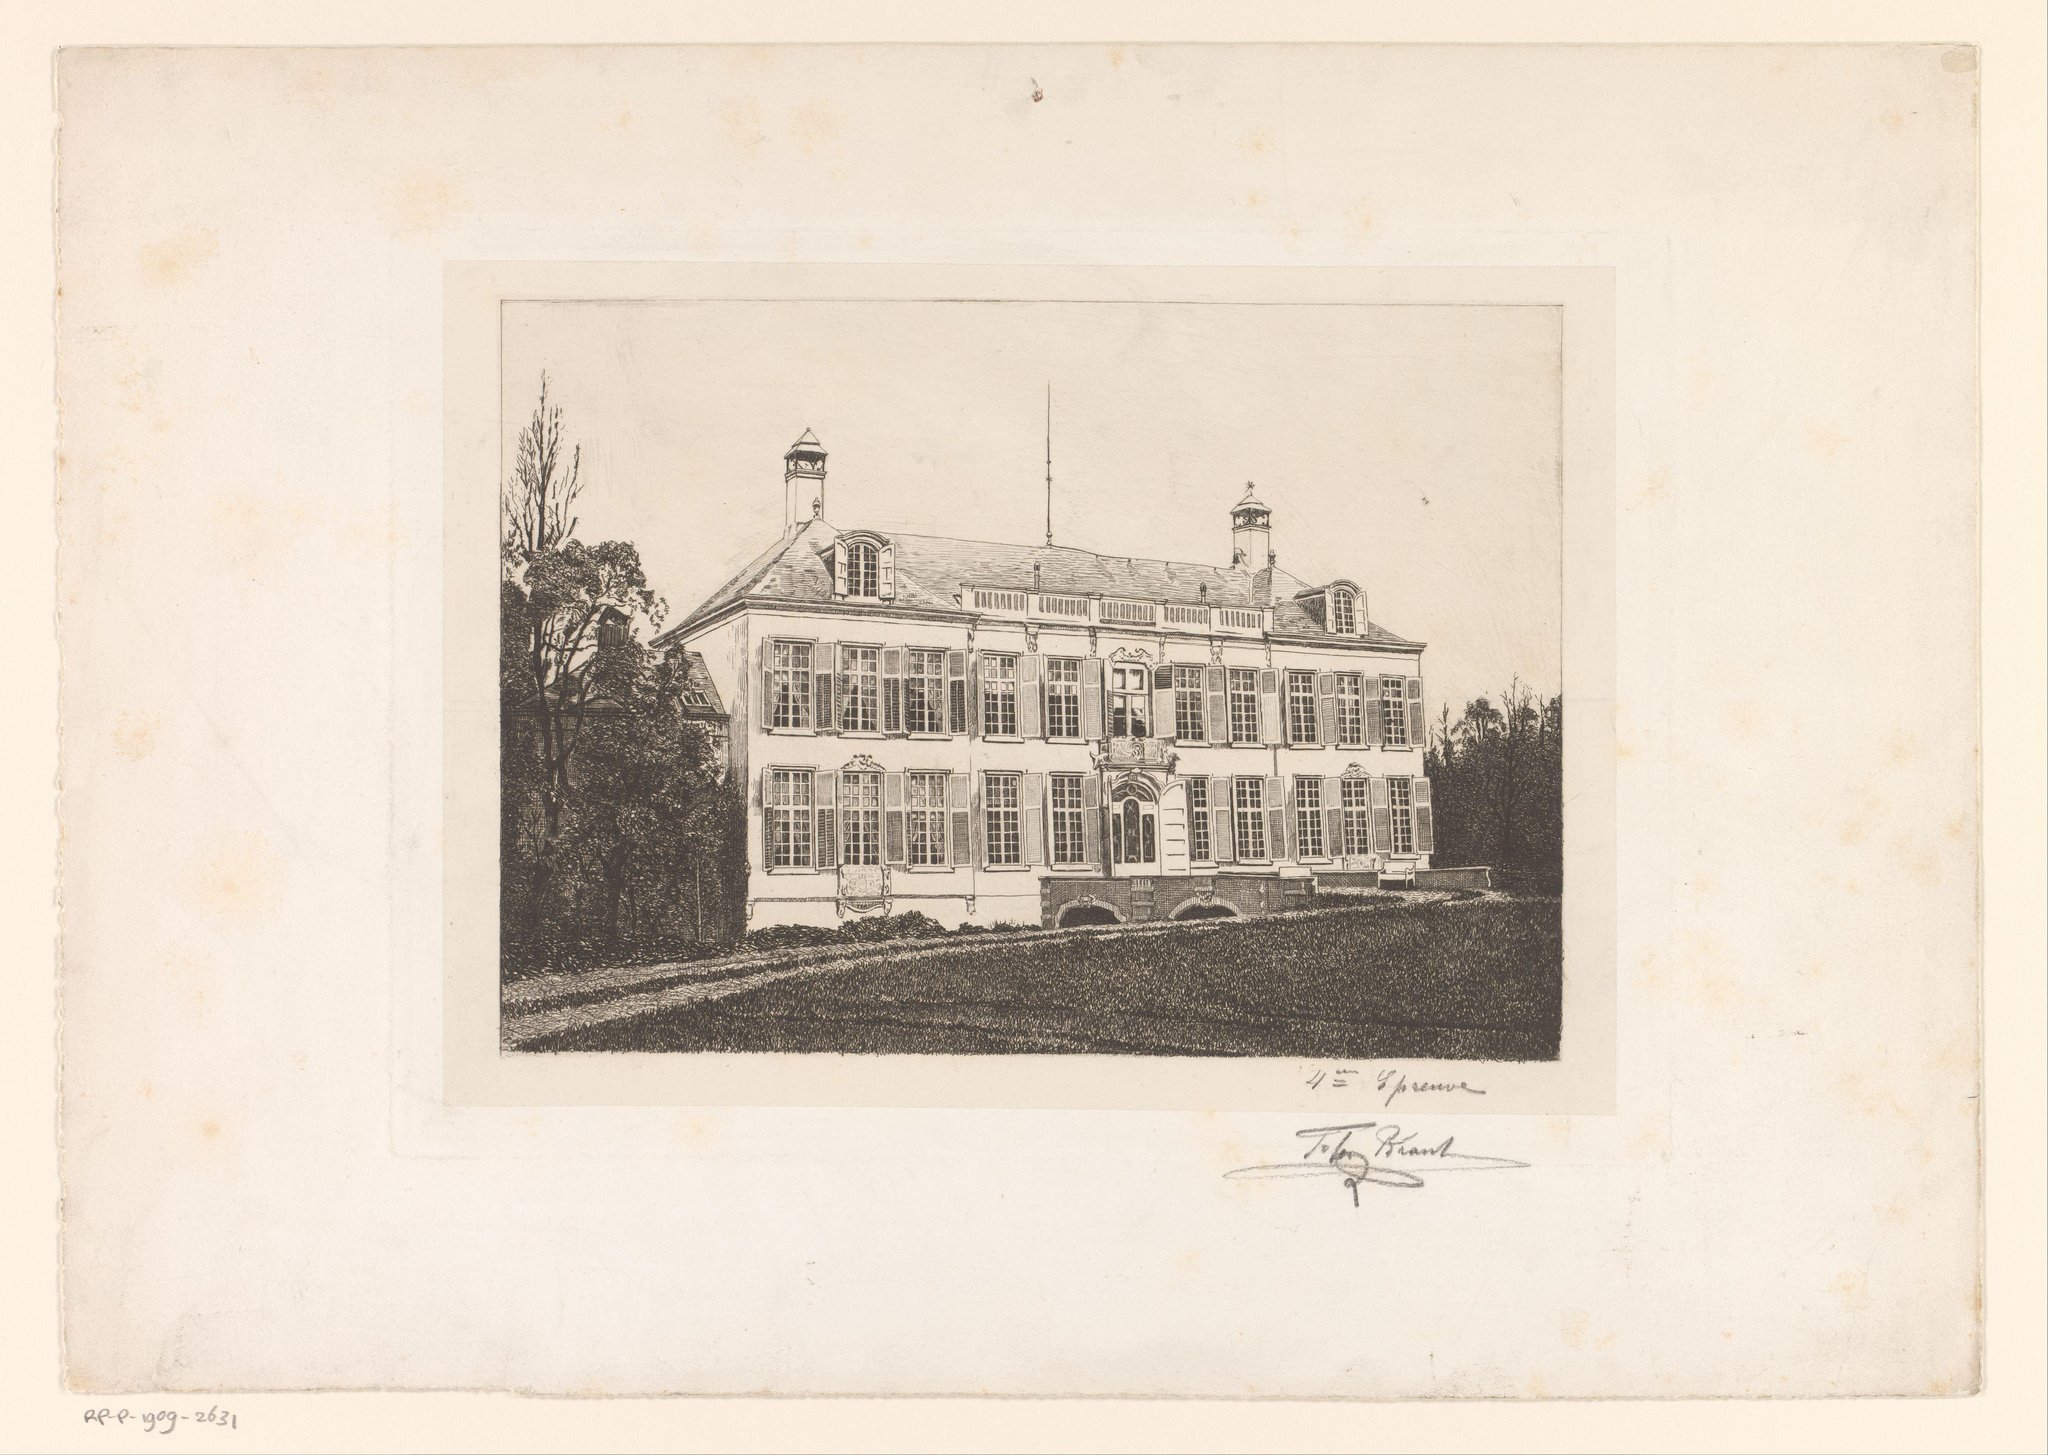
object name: print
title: Gezicht op een buitenhuis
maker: florent brant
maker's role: print maker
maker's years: 1863-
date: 1873-1909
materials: paper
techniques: etching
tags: castle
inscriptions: inscription: ‘4e Epreuve’, collector's mark: Lugt 2228